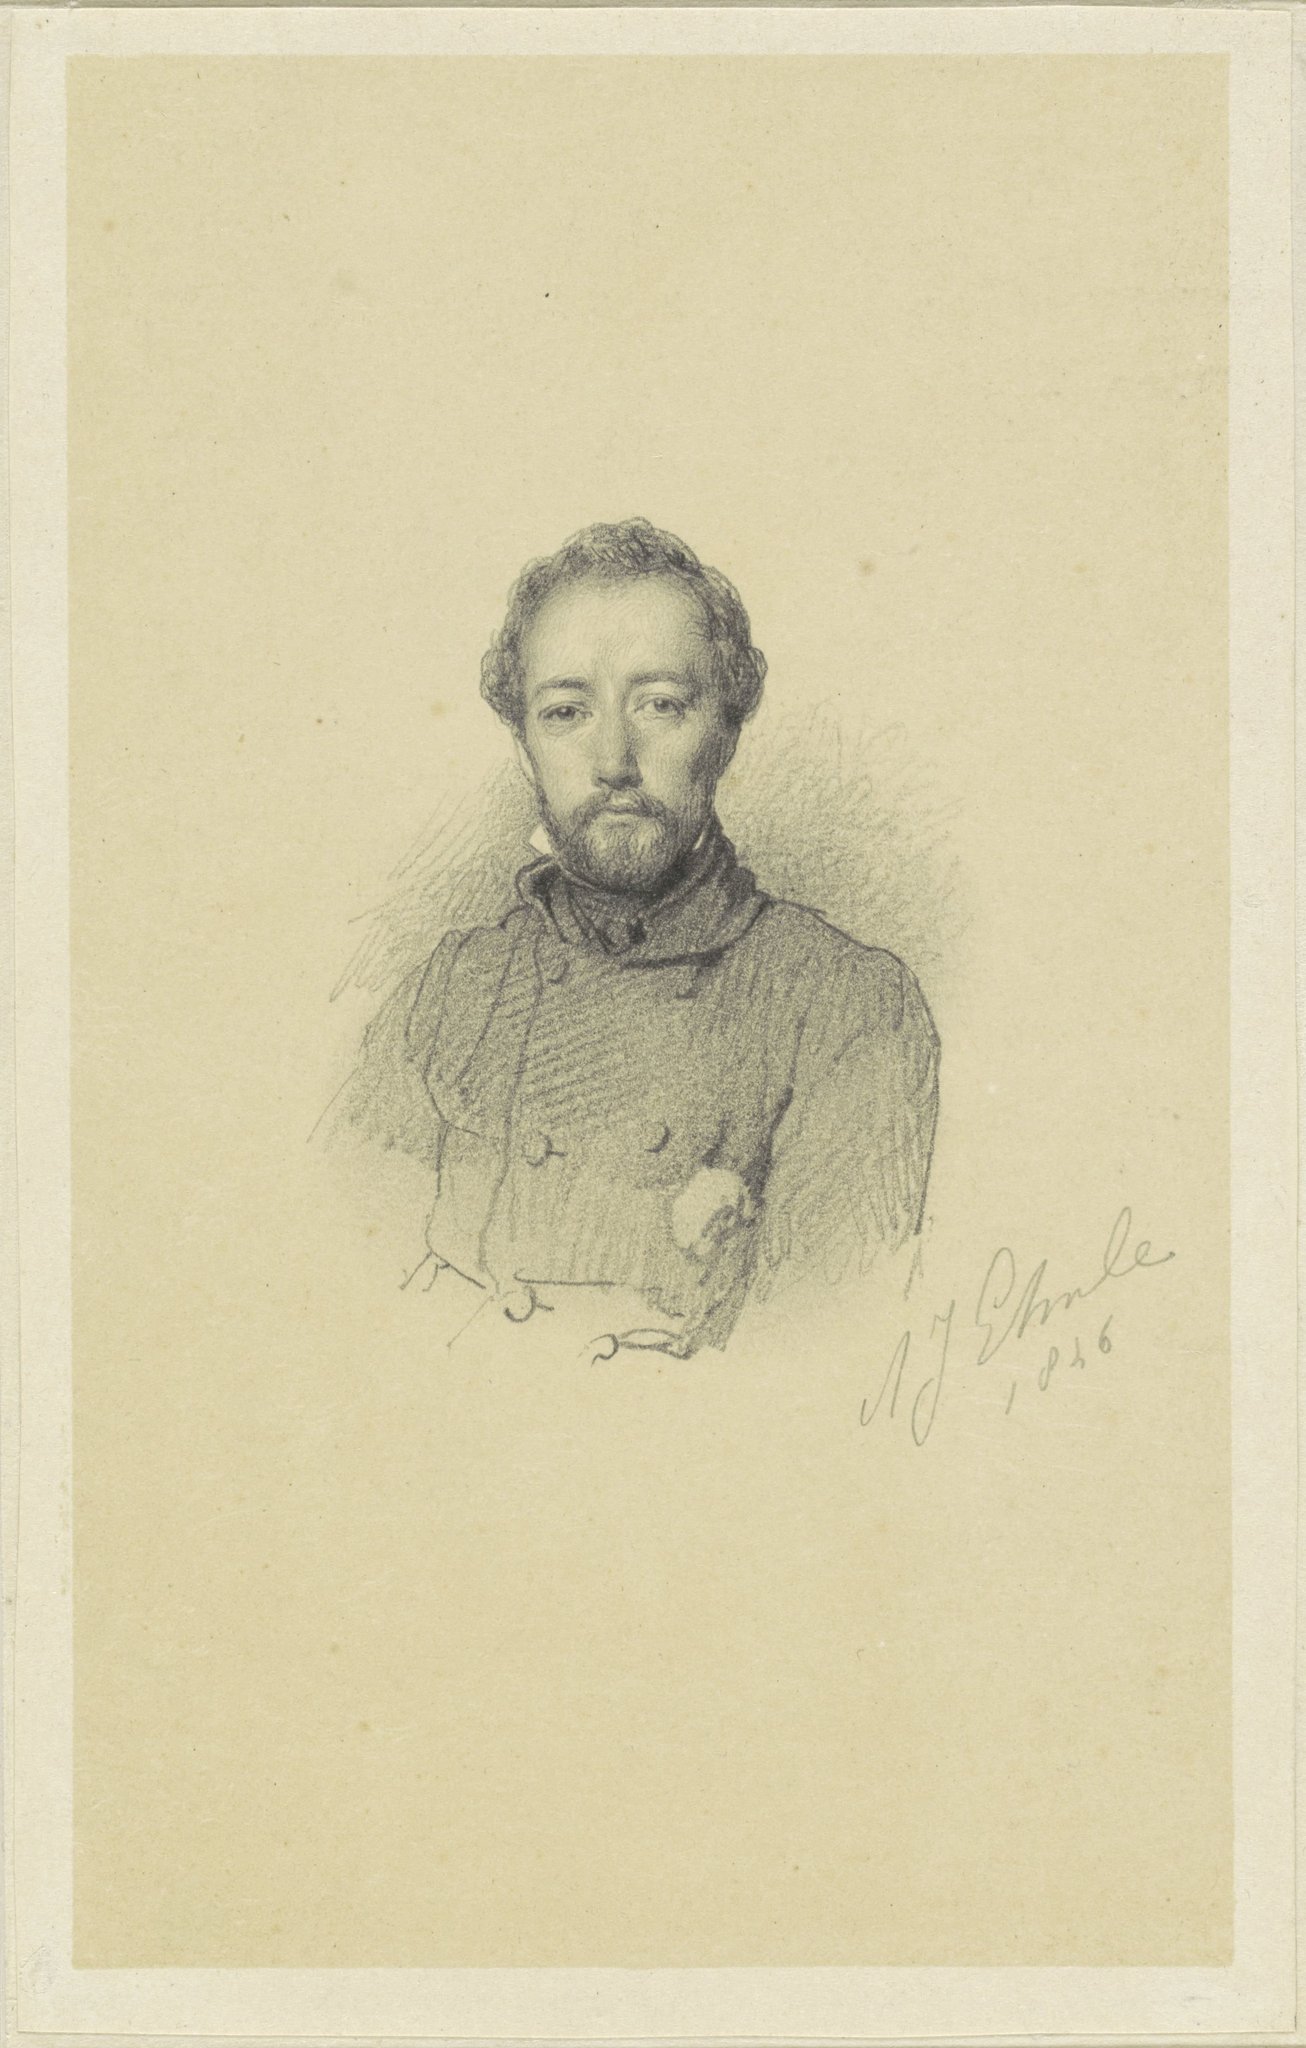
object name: drawing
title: Portret van Charles Rochussen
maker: adrianus johannes ehnle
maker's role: draughtsman, print maker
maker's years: 1819-1863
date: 1846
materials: paper, pencil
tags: painter, draughtsman, charles rochussen, historical persons, portrait, self-portrait of artist